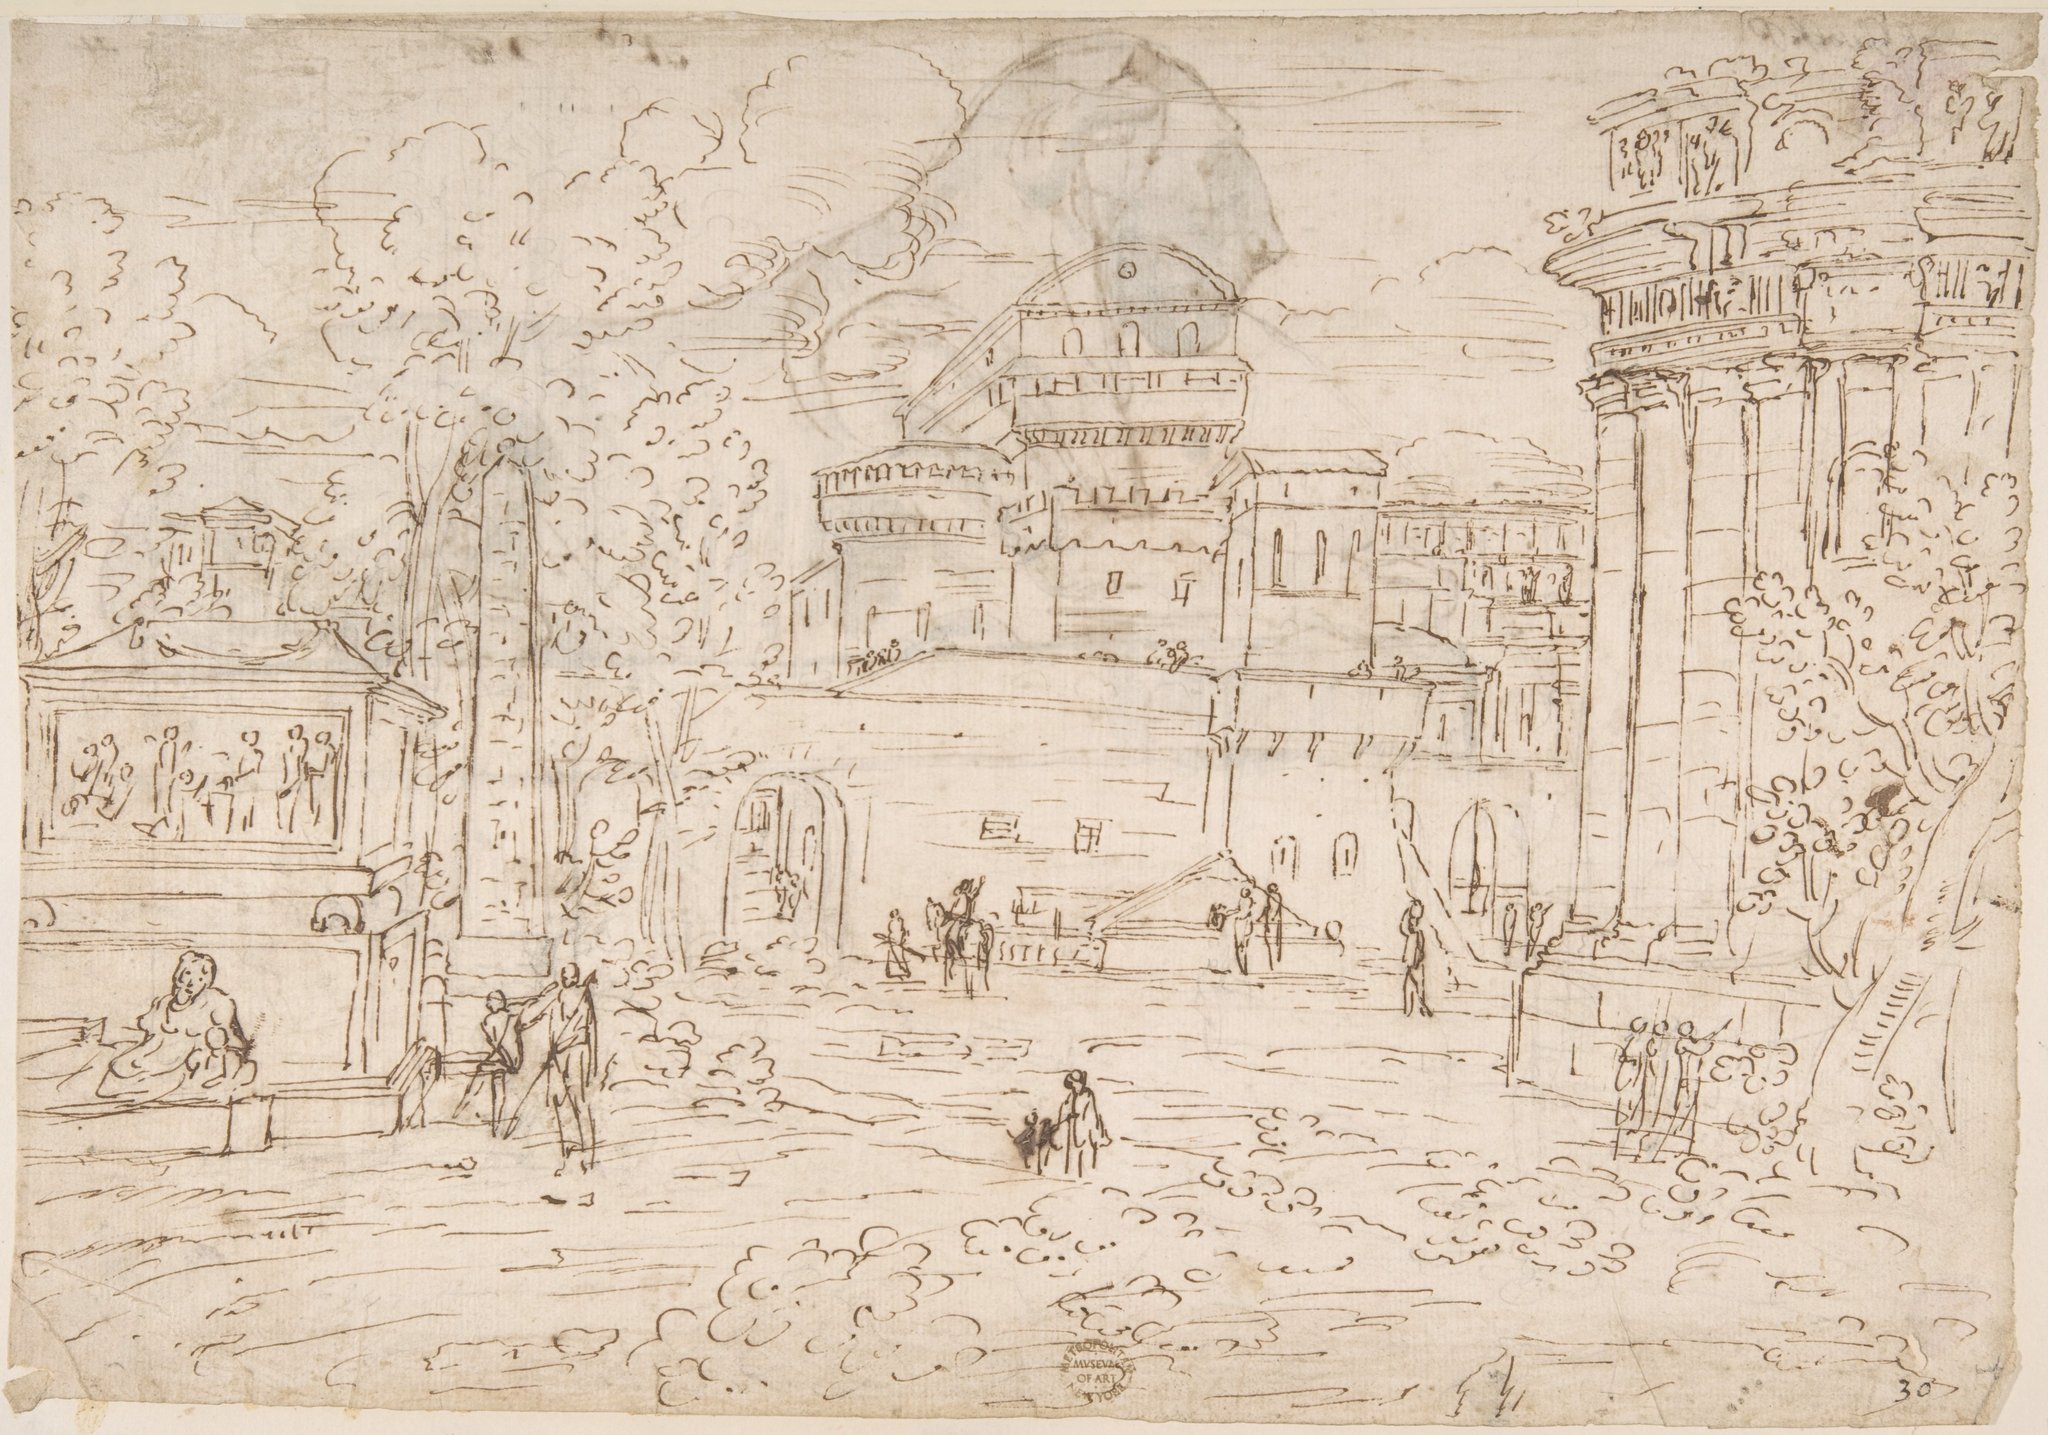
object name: drawing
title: Fantasy based on Vatican: Sistine Chapel, Loggia (identification by James S. Ackerman) (recto); A Lion (verso)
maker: anonymous, italian, roman-bolognese, 17th century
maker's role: artist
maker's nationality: italian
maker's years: 1600-1700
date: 1601-1700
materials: chalk, ink, paper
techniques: pen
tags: buildings,obelisks